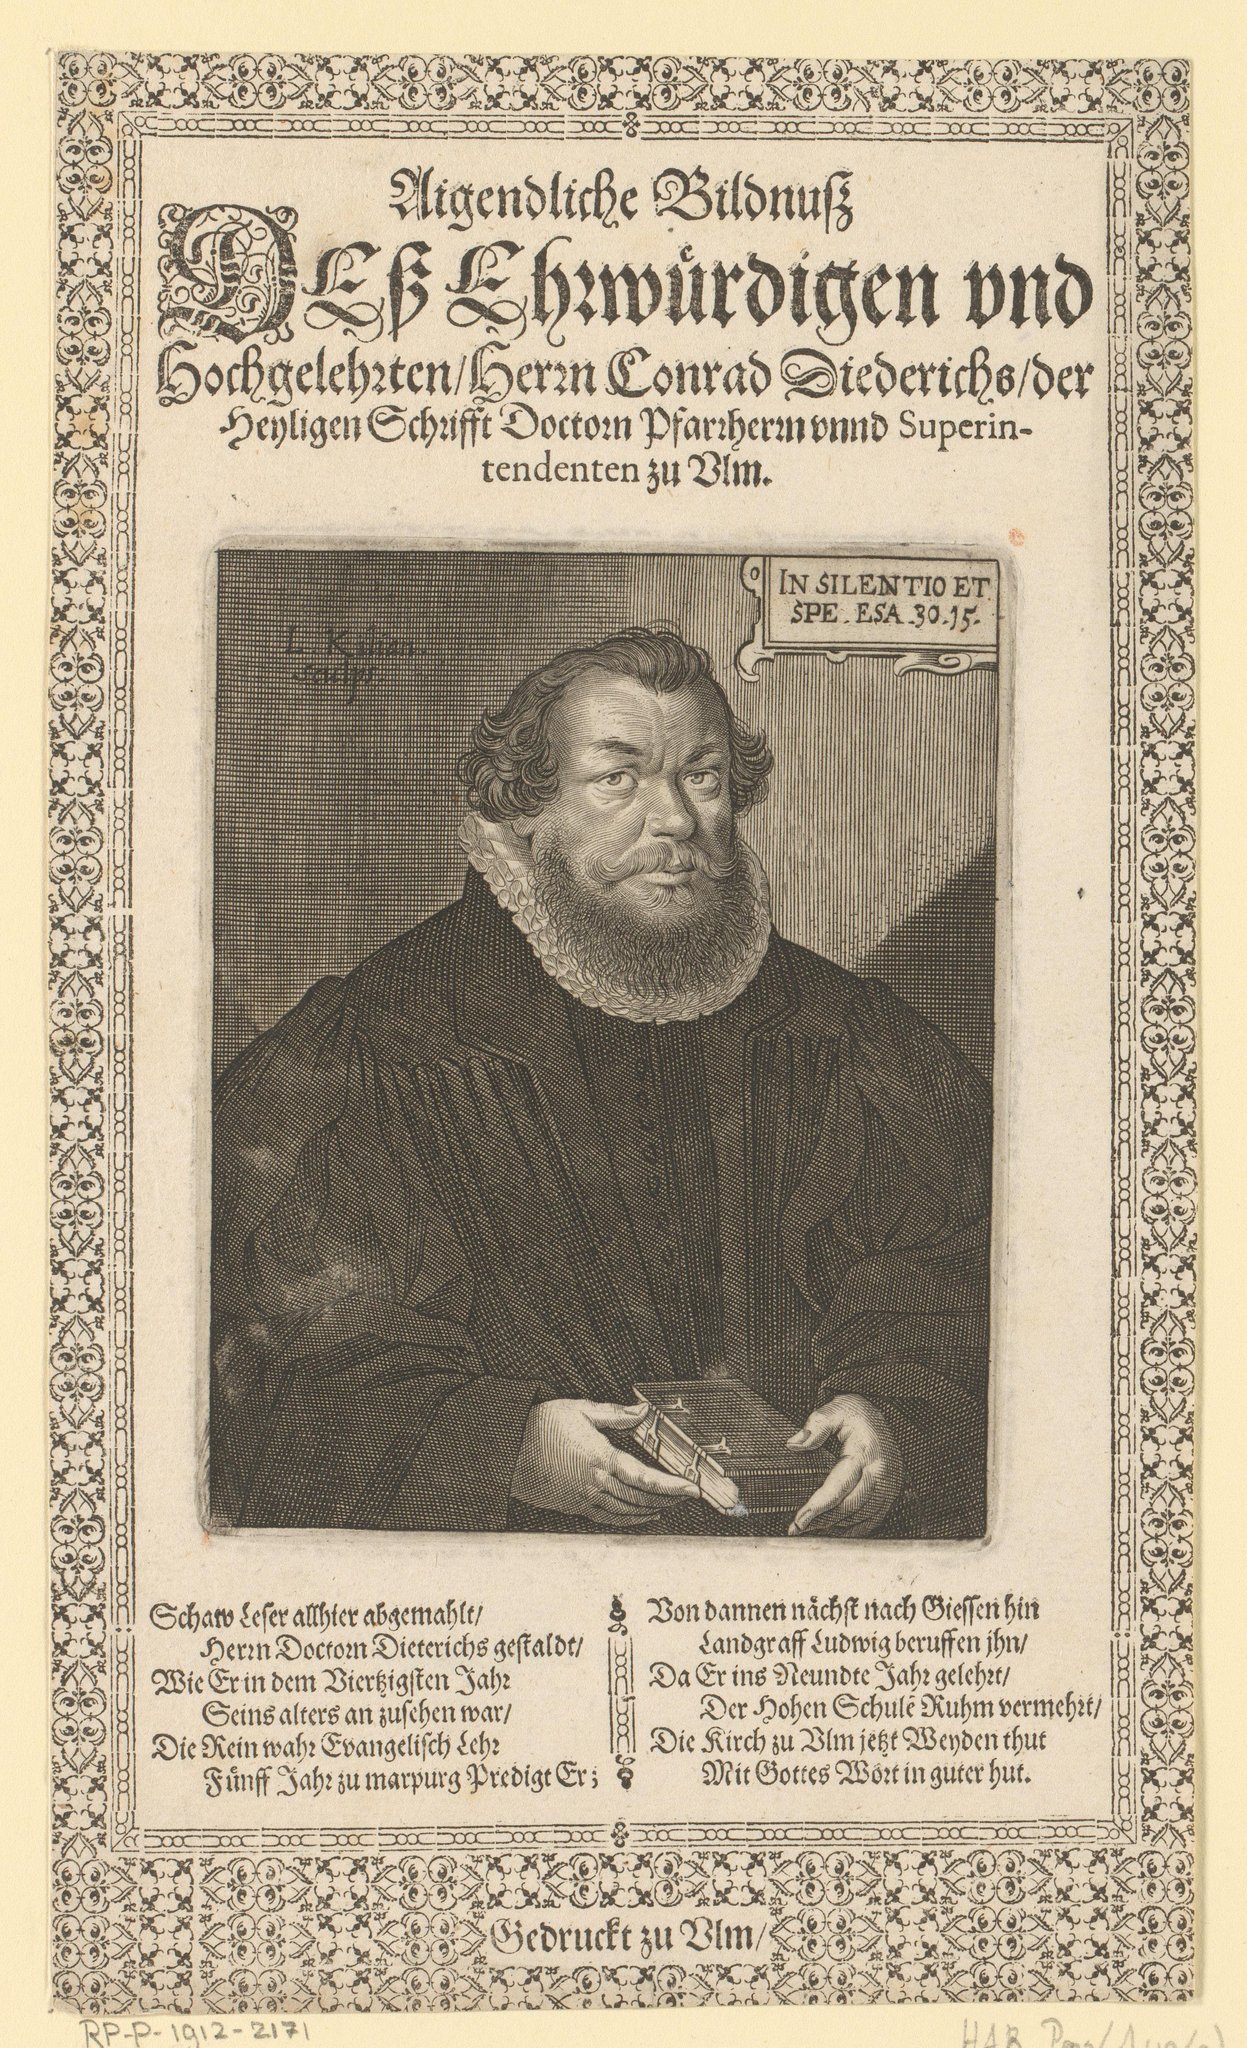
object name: print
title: Portret van Konrad Dieterich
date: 1615-1637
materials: paper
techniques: engraving, letterpress printing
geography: ulm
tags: historical persons, book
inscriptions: watermark, collector's mark: Lugt 2228